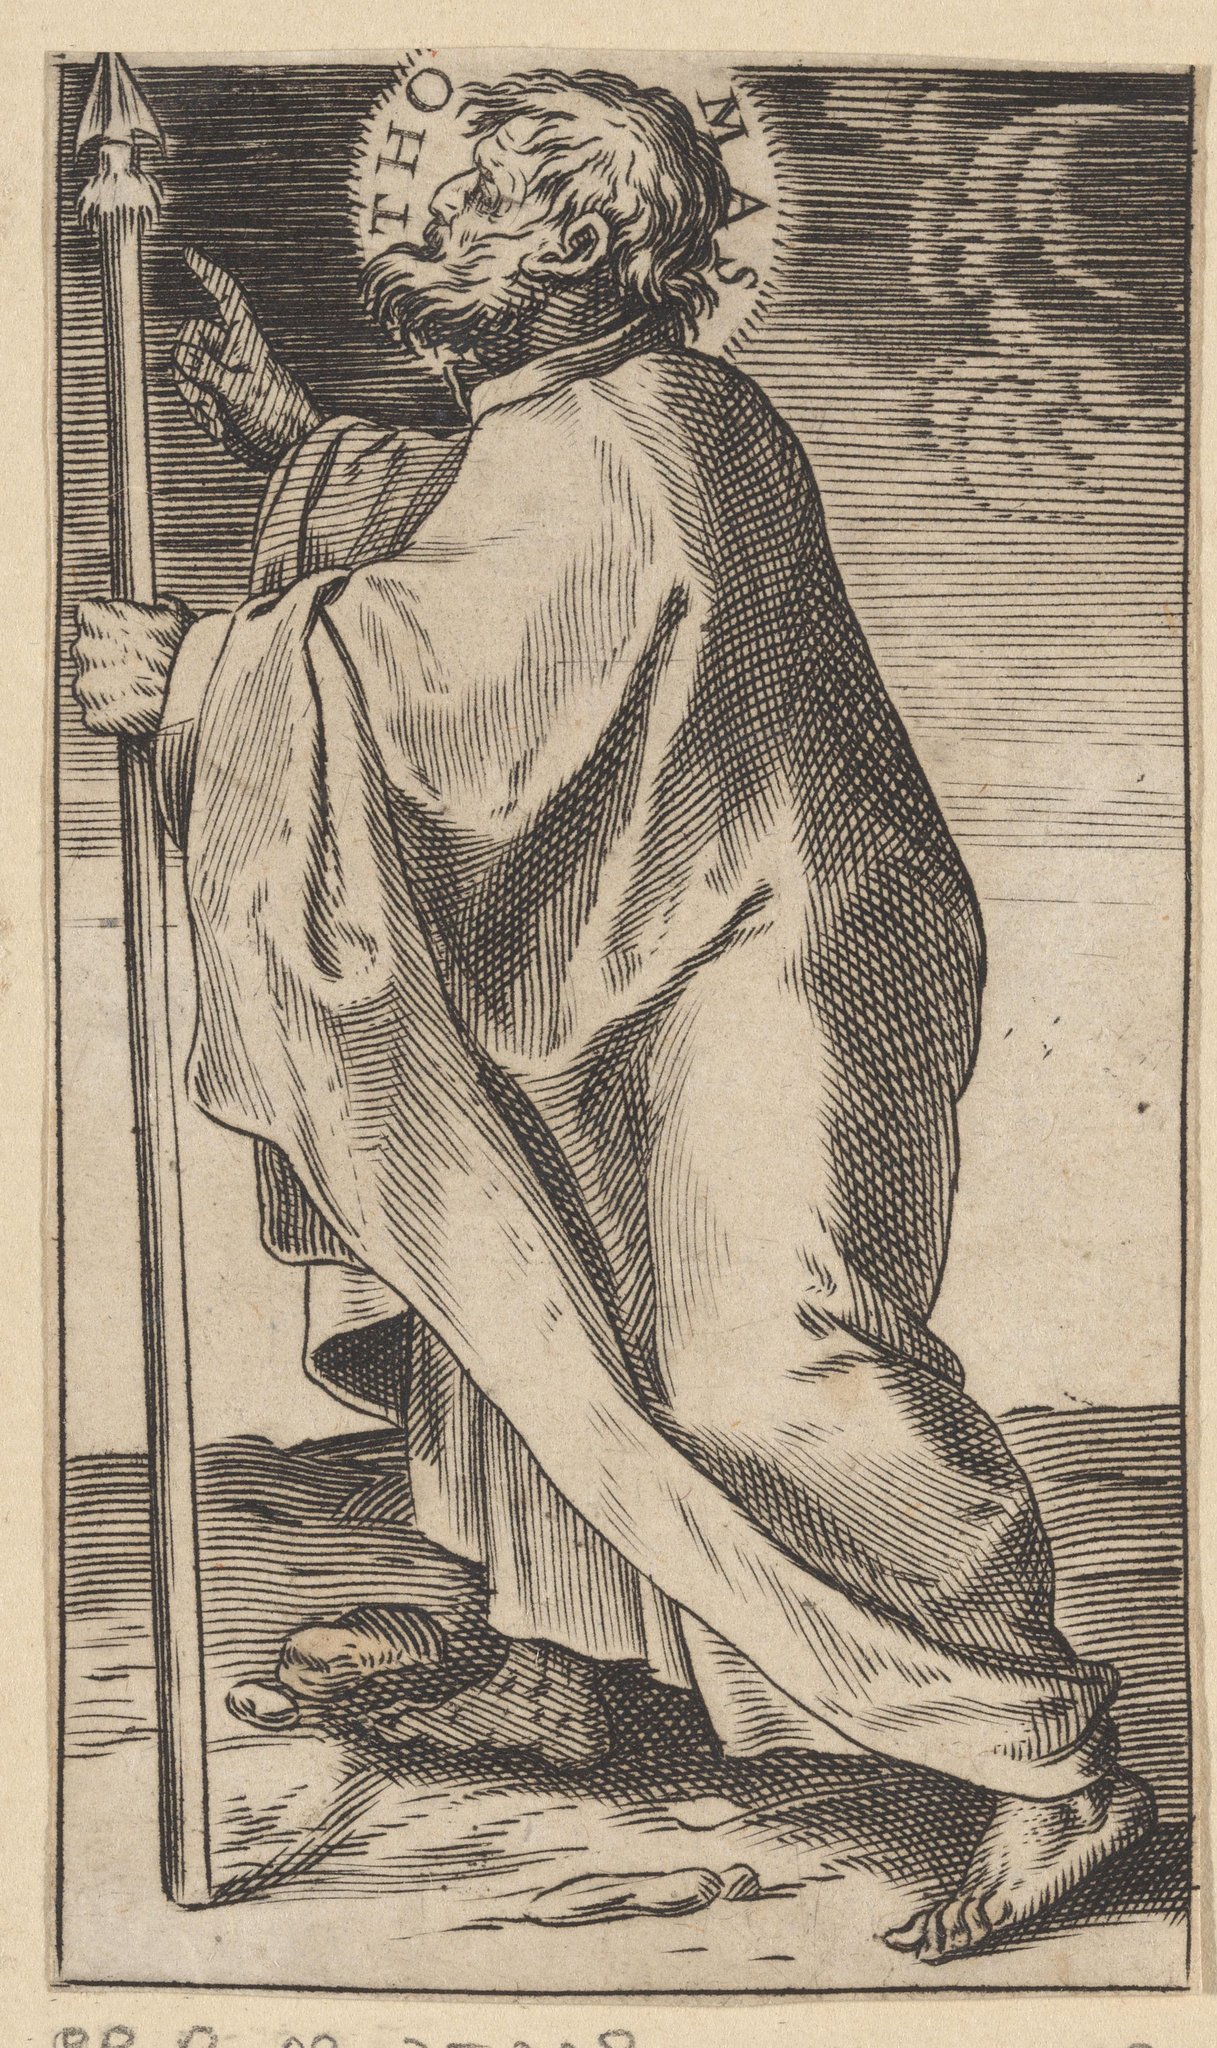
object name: print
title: Christus, Maria, Johannes de Doper en de apostelen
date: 1583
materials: paper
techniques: engraving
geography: italy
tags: the apostle thomas; possible attributes: book, chalice, girdle, heart, lance or spear, scroll, square, stones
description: Afbeelding gesneden uit een blad met drie voorstellingen van de apostelen Bartolomeüs met een mes, Tomas met een speer en Petrus met twee sleutels en een boek.